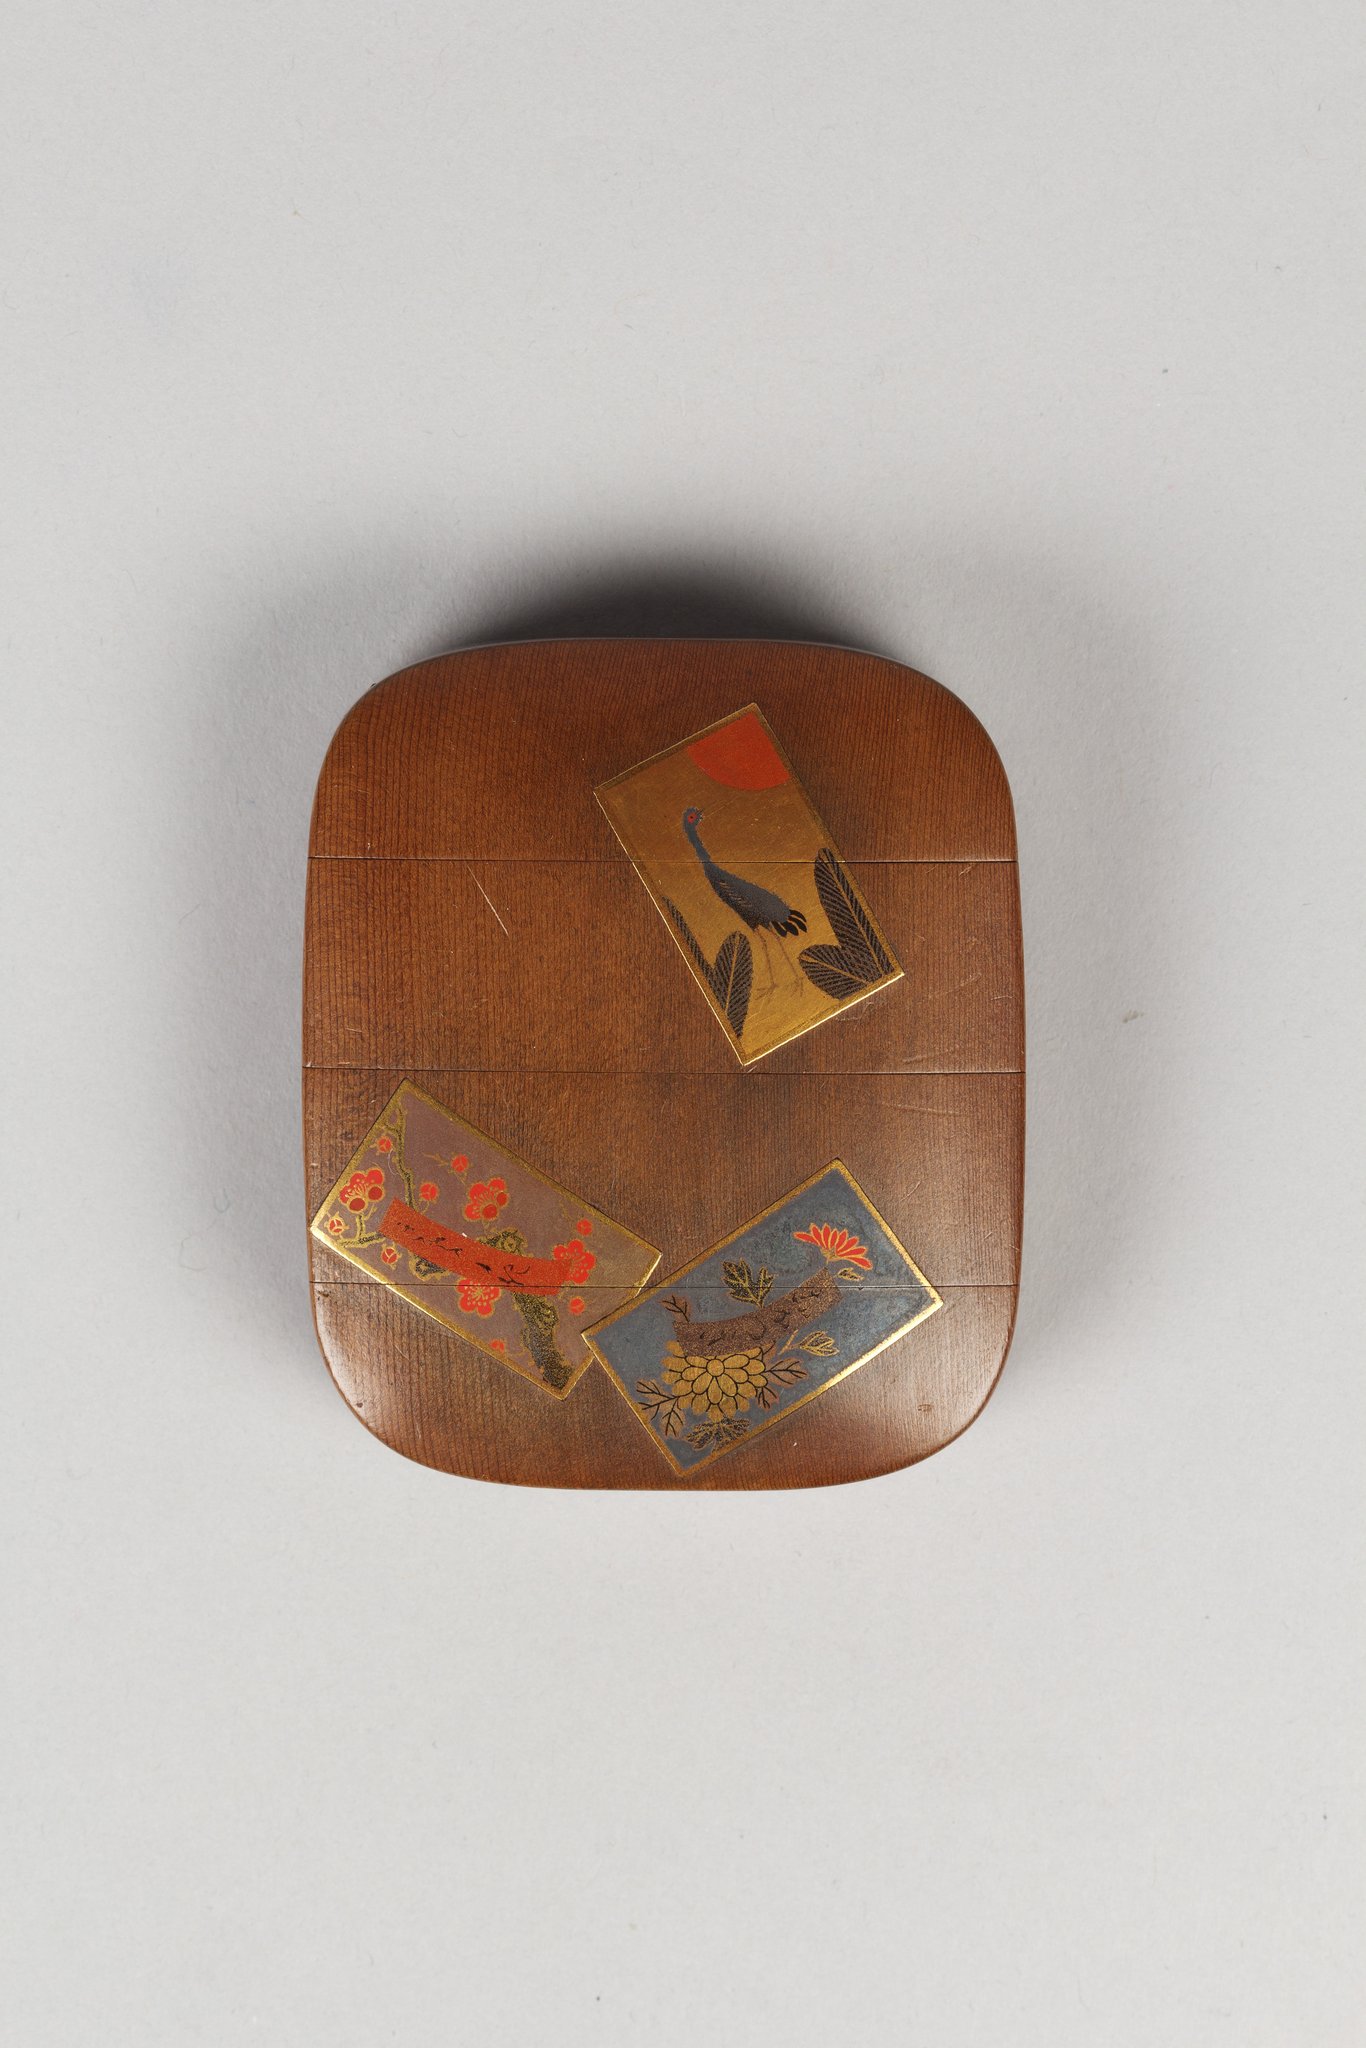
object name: inrō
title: Case (Inrō) with Design of Poem Cards with Crane and Pine, Plum, Cherry, Chrysanthemum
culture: japanese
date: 1867-1900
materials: gold, wood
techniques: hiramakie, polish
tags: cranes